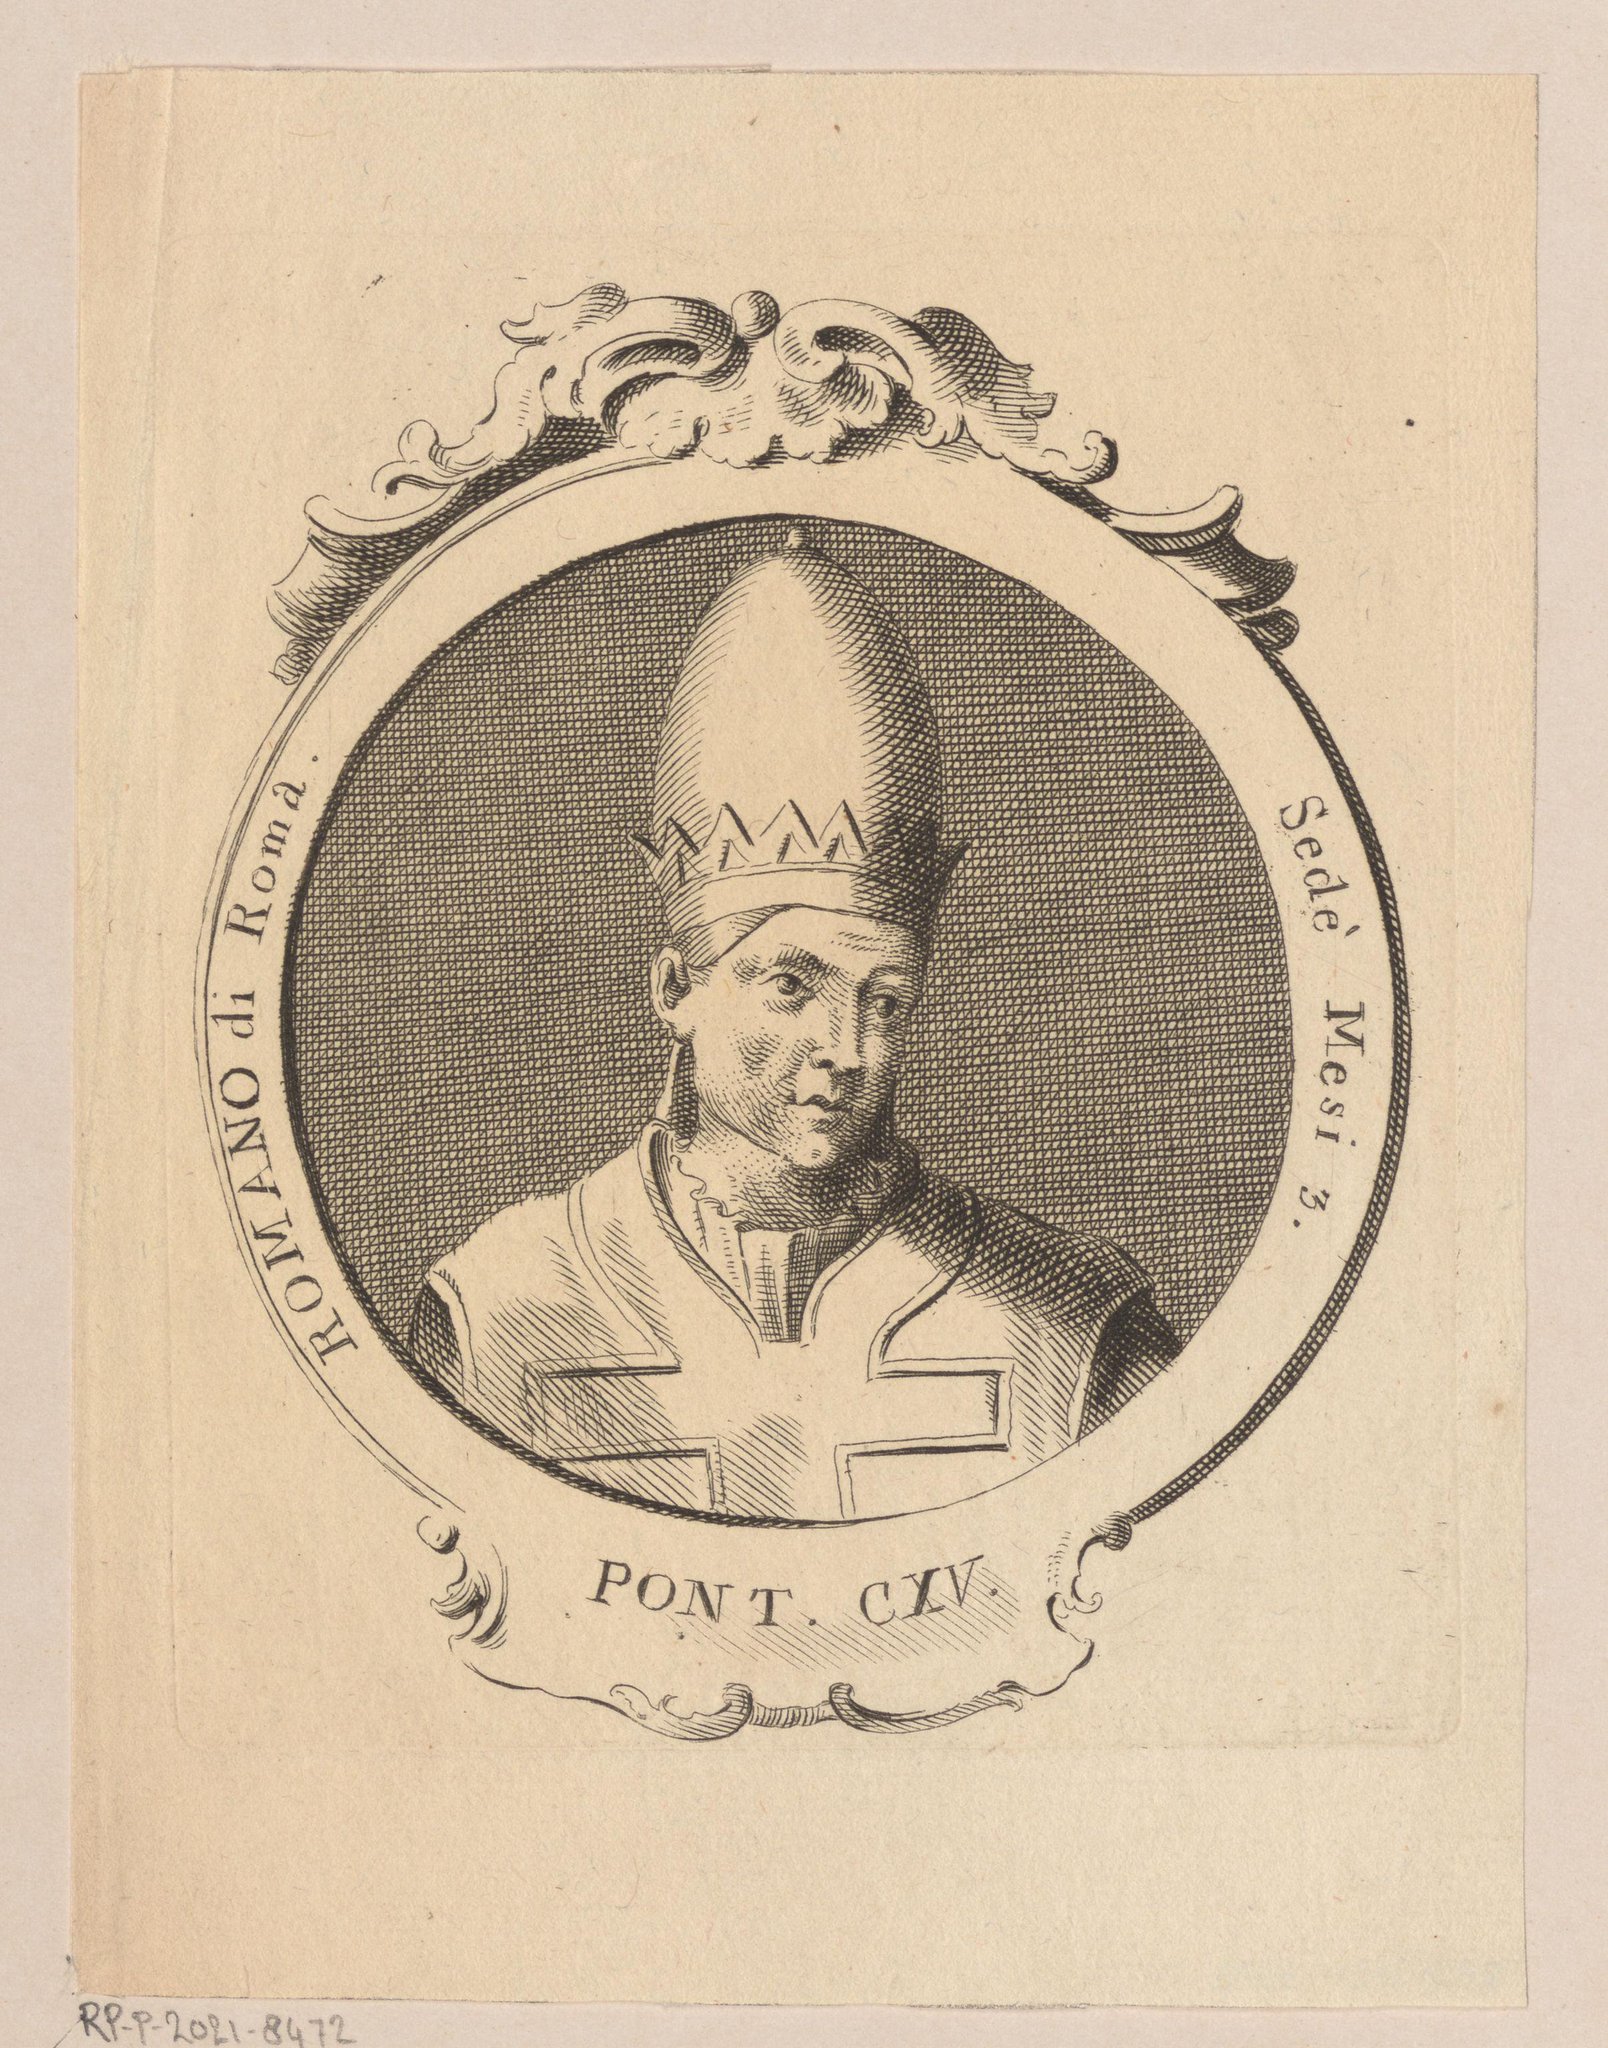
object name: print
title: Portret van Romanus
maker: Anonymous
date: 1775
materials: paper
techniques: engraving, etching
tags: historical persons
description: Prent waarschijnlijk uit: Effigies Romanorum pontificum a S. Petro ad Pium VI (...). 2 dln. Venetië en Bassano del Grappa: Giuseppe Remondini, 1775, dl. 1.